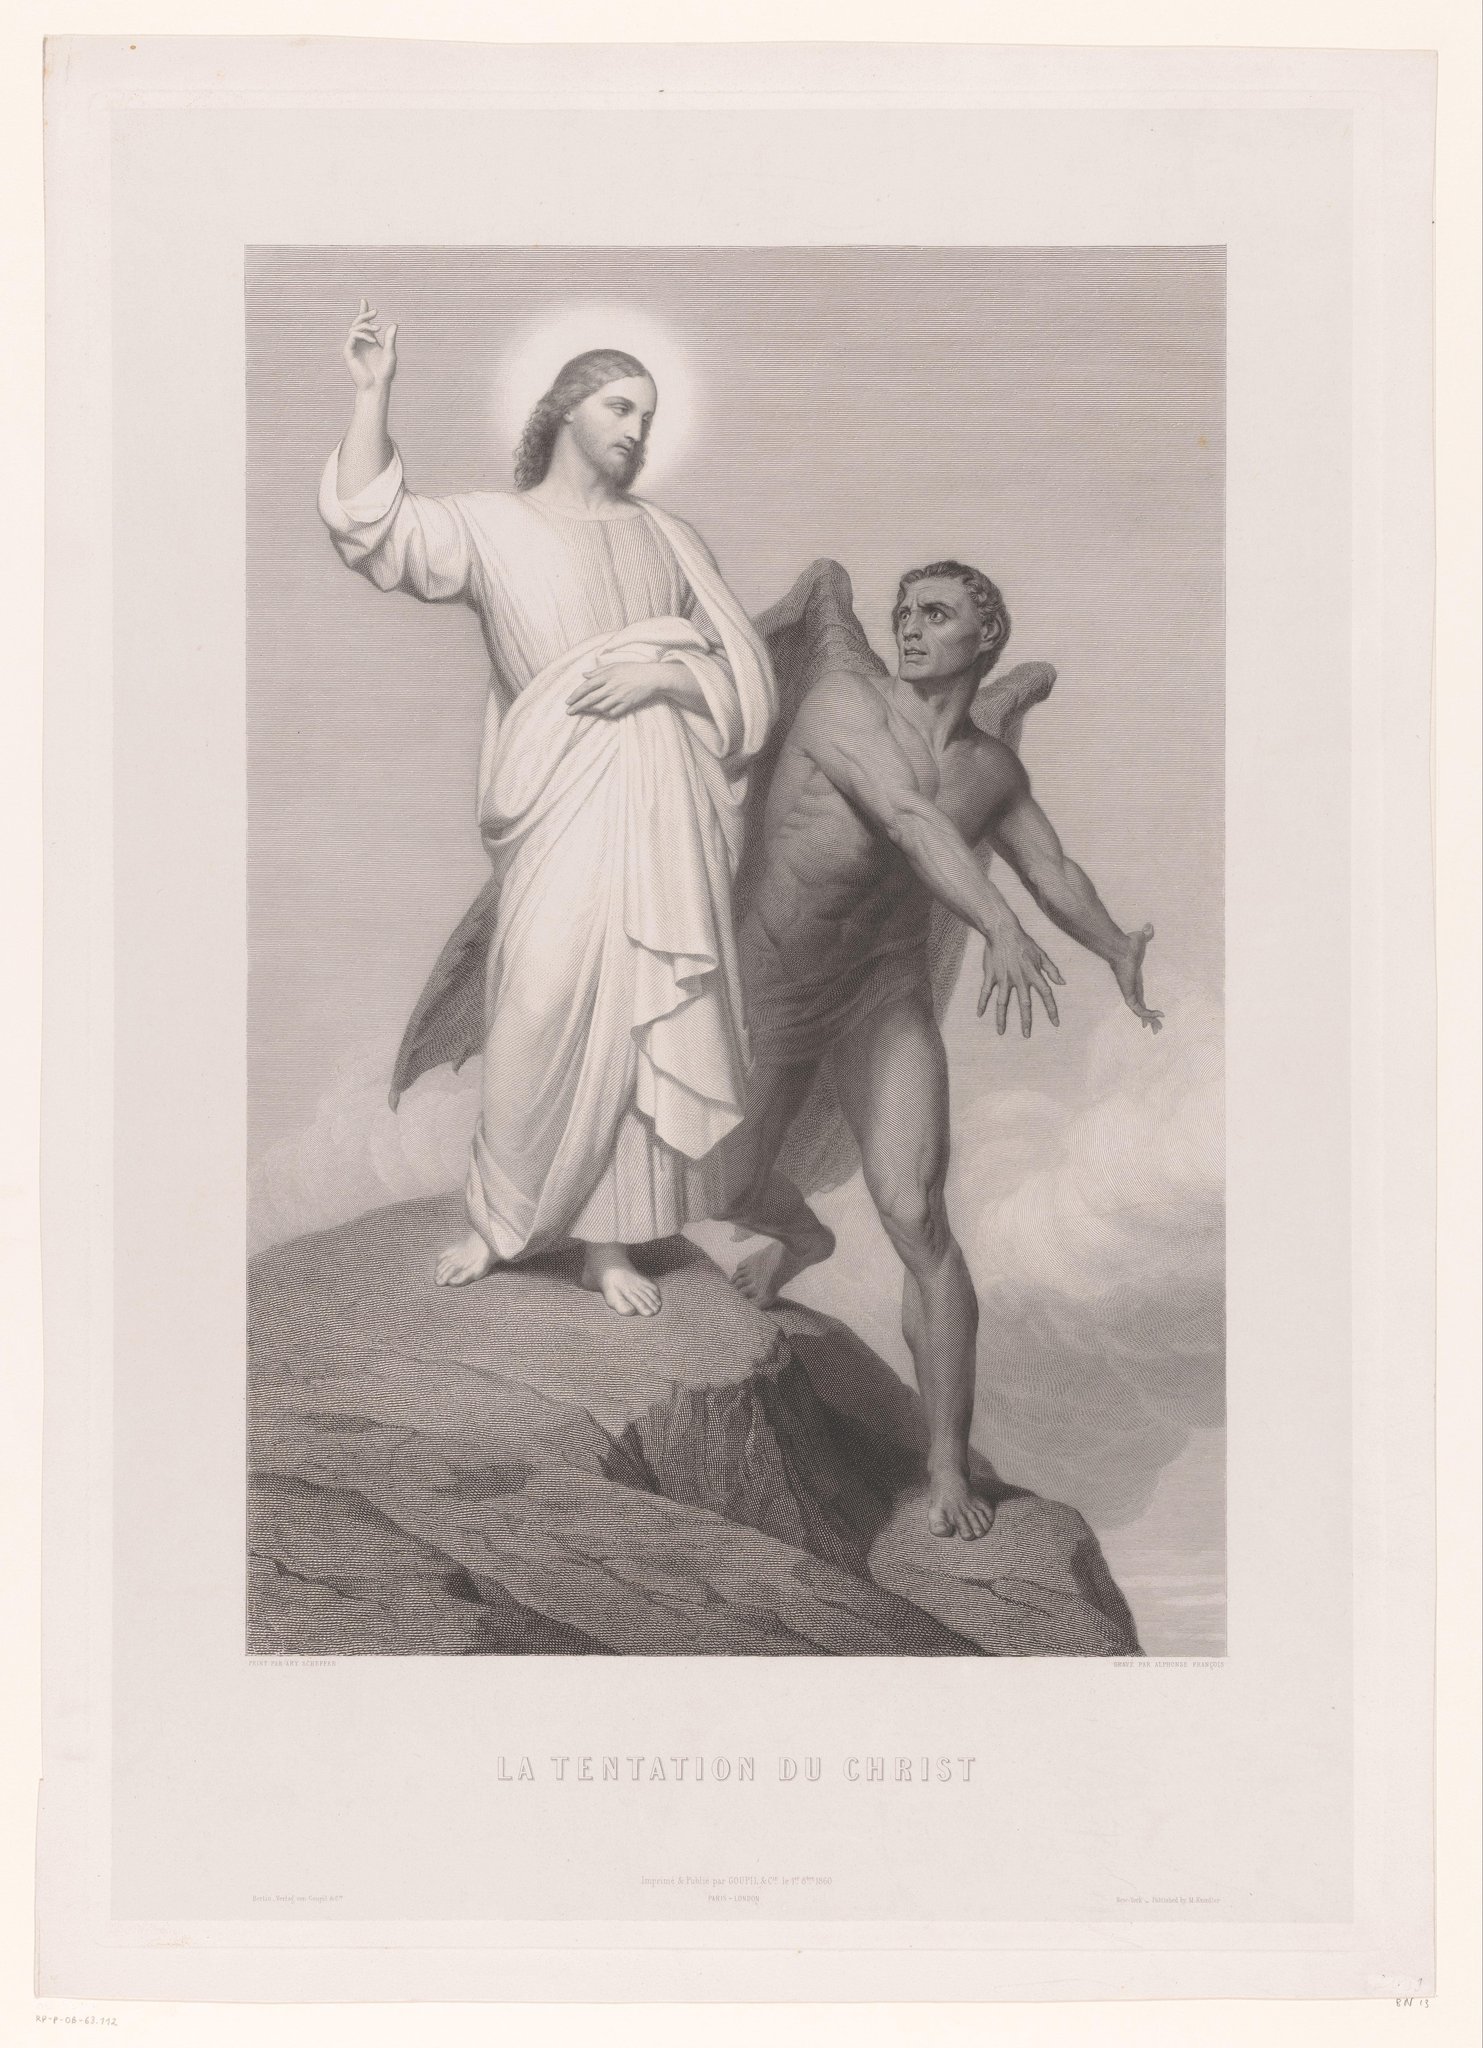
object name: print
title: La tentation du Christ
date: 1860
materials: paper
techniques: engraving, etching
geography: london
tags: 'command these stones to become loaves of bread' ~ temptation of christ in the wilderness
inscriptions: collector's mark: Lugt 2228